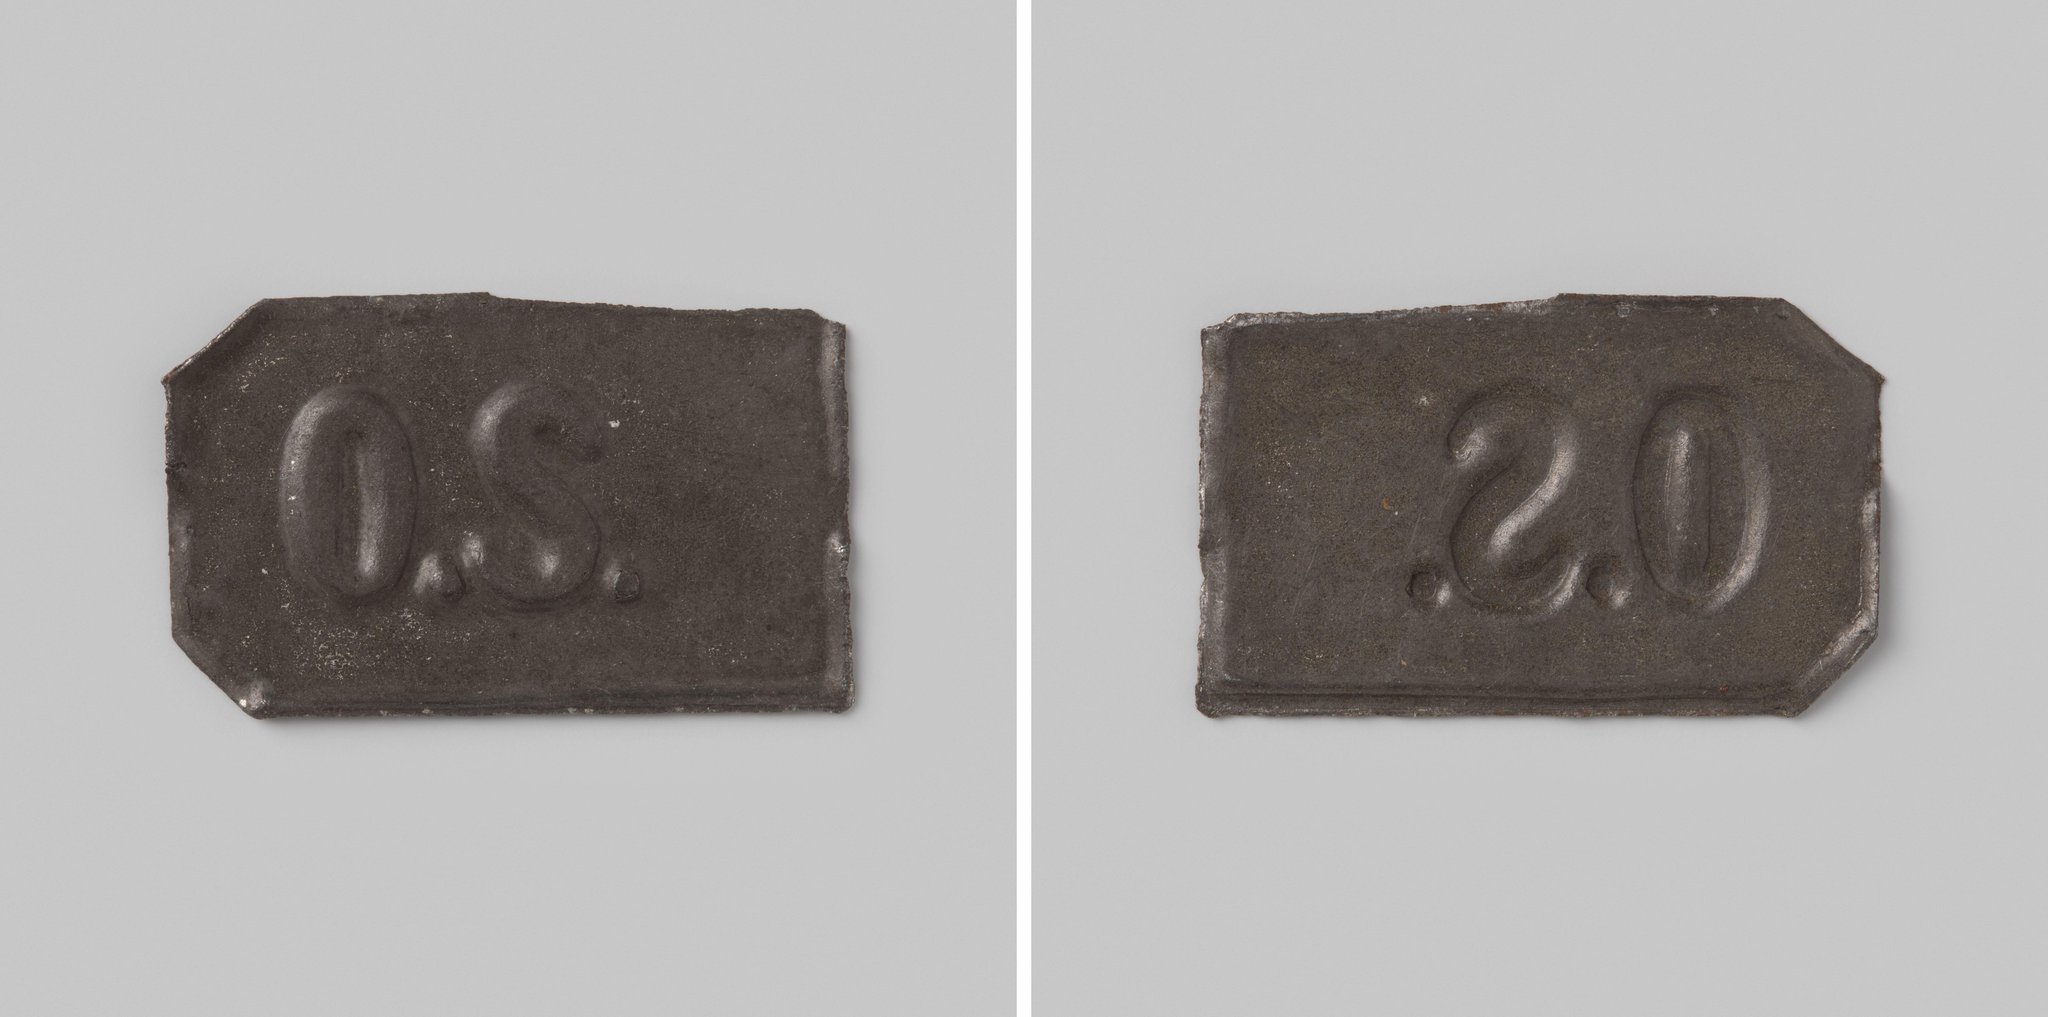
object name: huismunt prison money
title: Huismunt of plaatje van onbekende instelling, mogelijk van strafgevangenis Ommerschans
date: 1820-1850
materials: iron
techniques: pressing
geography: netherlands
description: Rechthoekig uitgeknipt stukje blik met links twee afgeschuinde hoeken en ingeperst de tekst O.S.